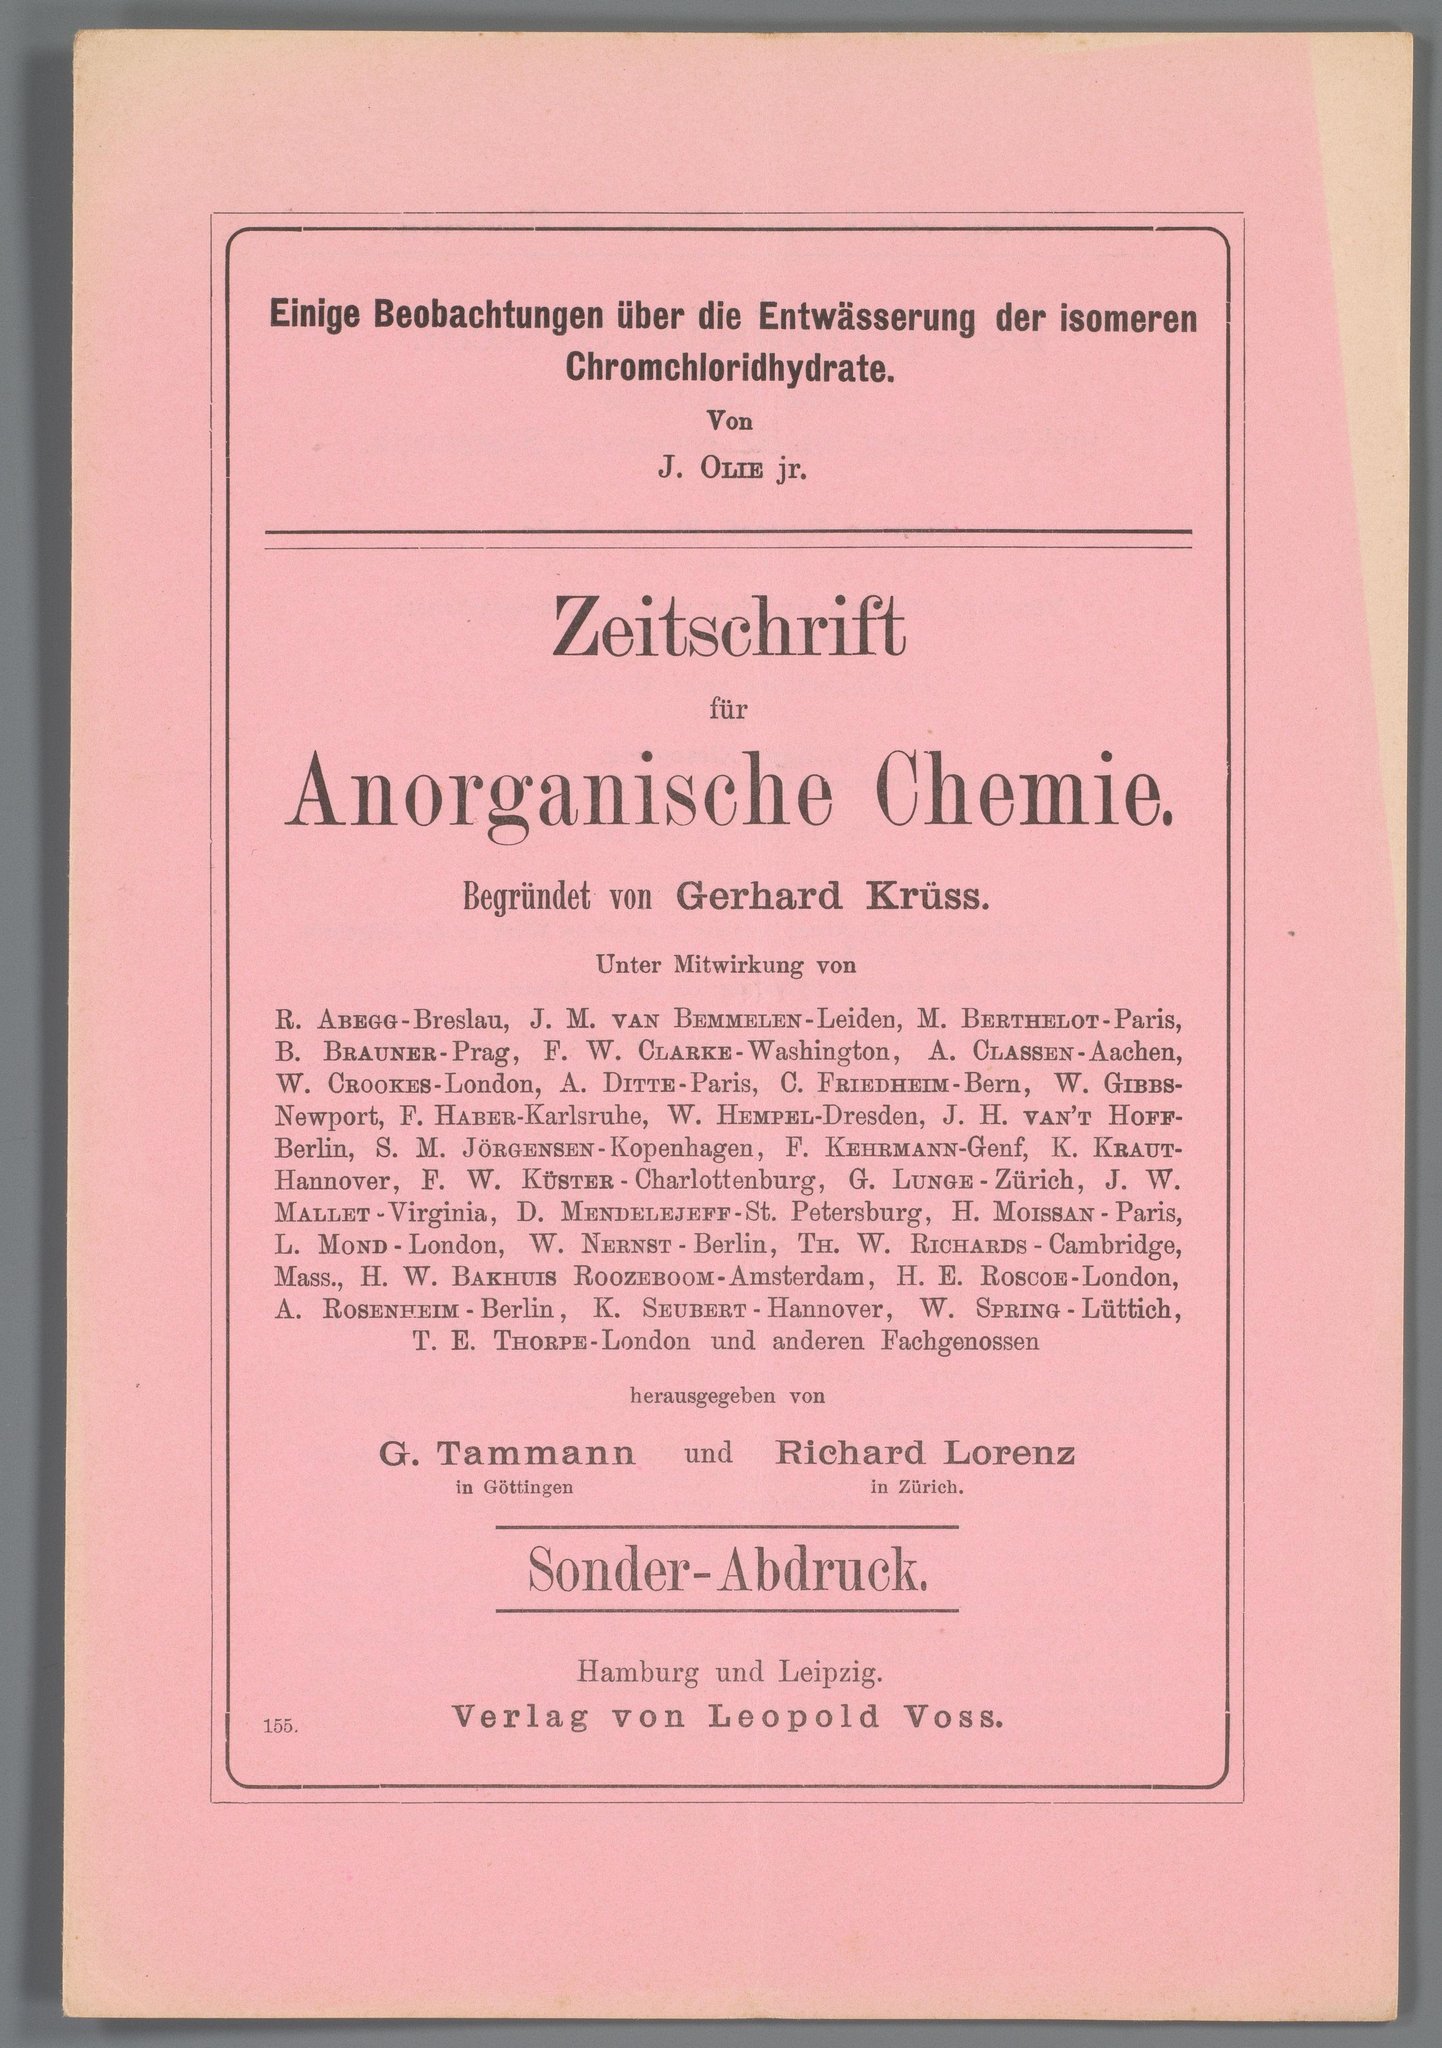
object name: offprint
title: Zeitschrift für Anorganische Chemie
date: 1906-1907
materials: paper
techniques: letterpress printing, engraving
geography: leipzig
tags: printed matter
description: Overdruk uit het 'Zeitschrift für Anorganische Chemie'.